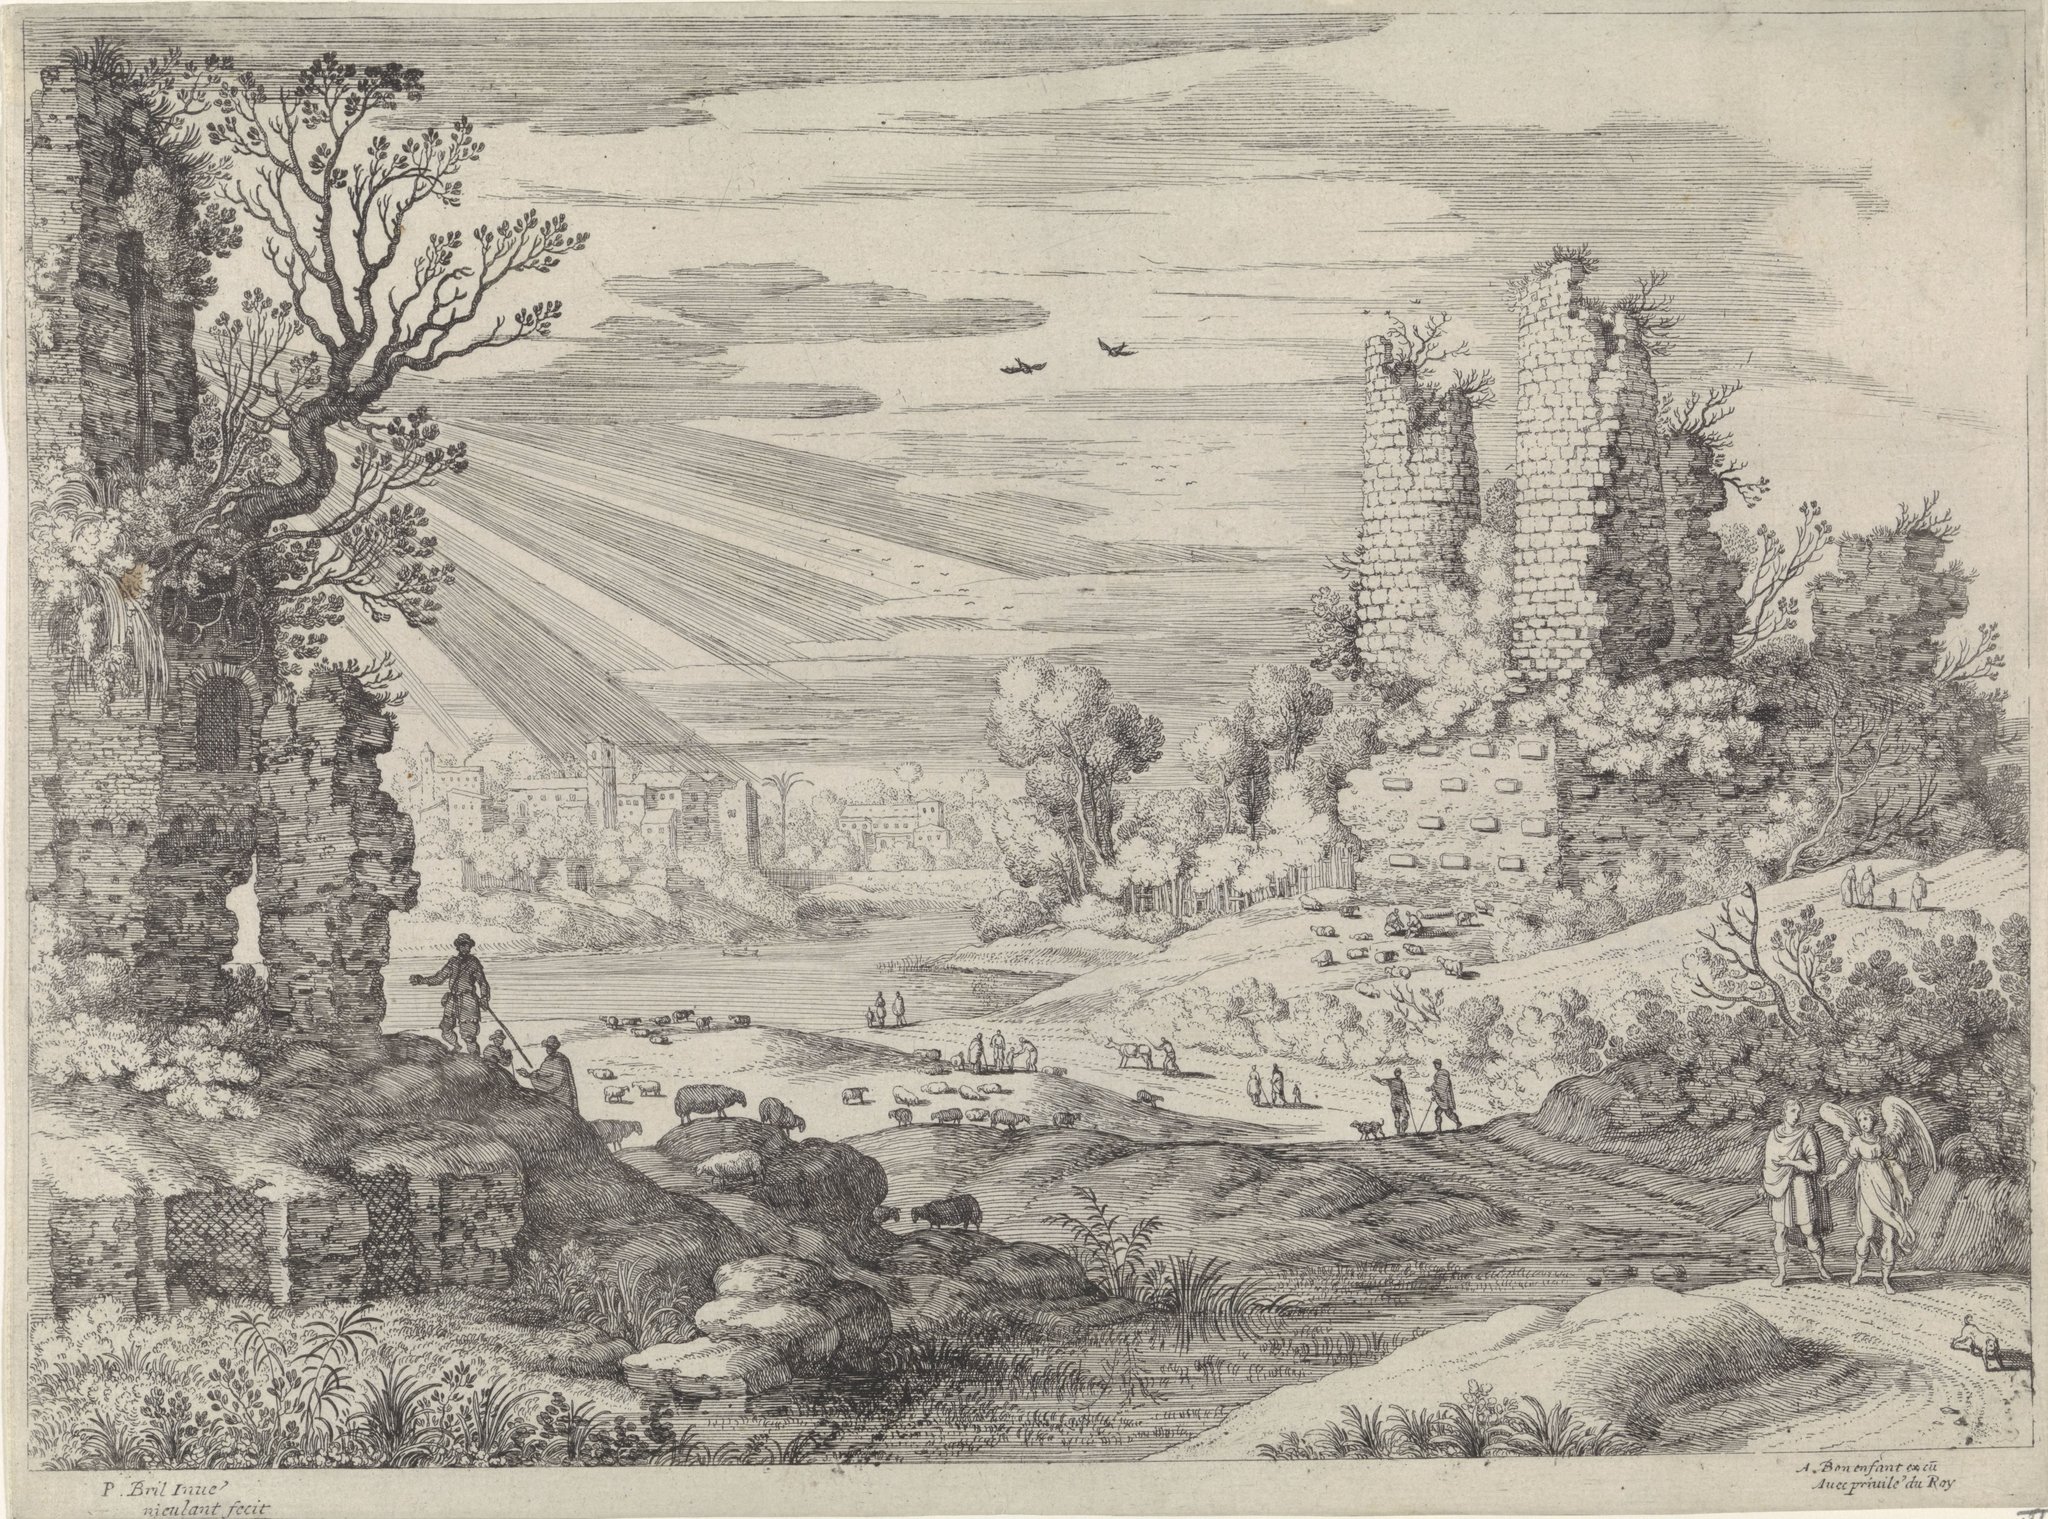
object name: print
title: Italiaans landschap met Tobias en de engel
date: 1594-1635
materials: paper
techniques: engraving, etching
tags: tobias and the angel raphael travelling, accompanied by tobias' dog, herding, herdsman, herdswoman, shepherd, shepherdess, cowherd, etc., landscape with ruins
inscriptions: collector's mark: Lugt 2228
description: In een Italiaans landschap met begroeide ruïnes zijn Tobias en de engel op weg. Voor hen uit loopt de hond van Tobias. In het landschap lopen verschillende figuren en herders met hun schapen. Aan de overzijde van een rivier ligt een stad.